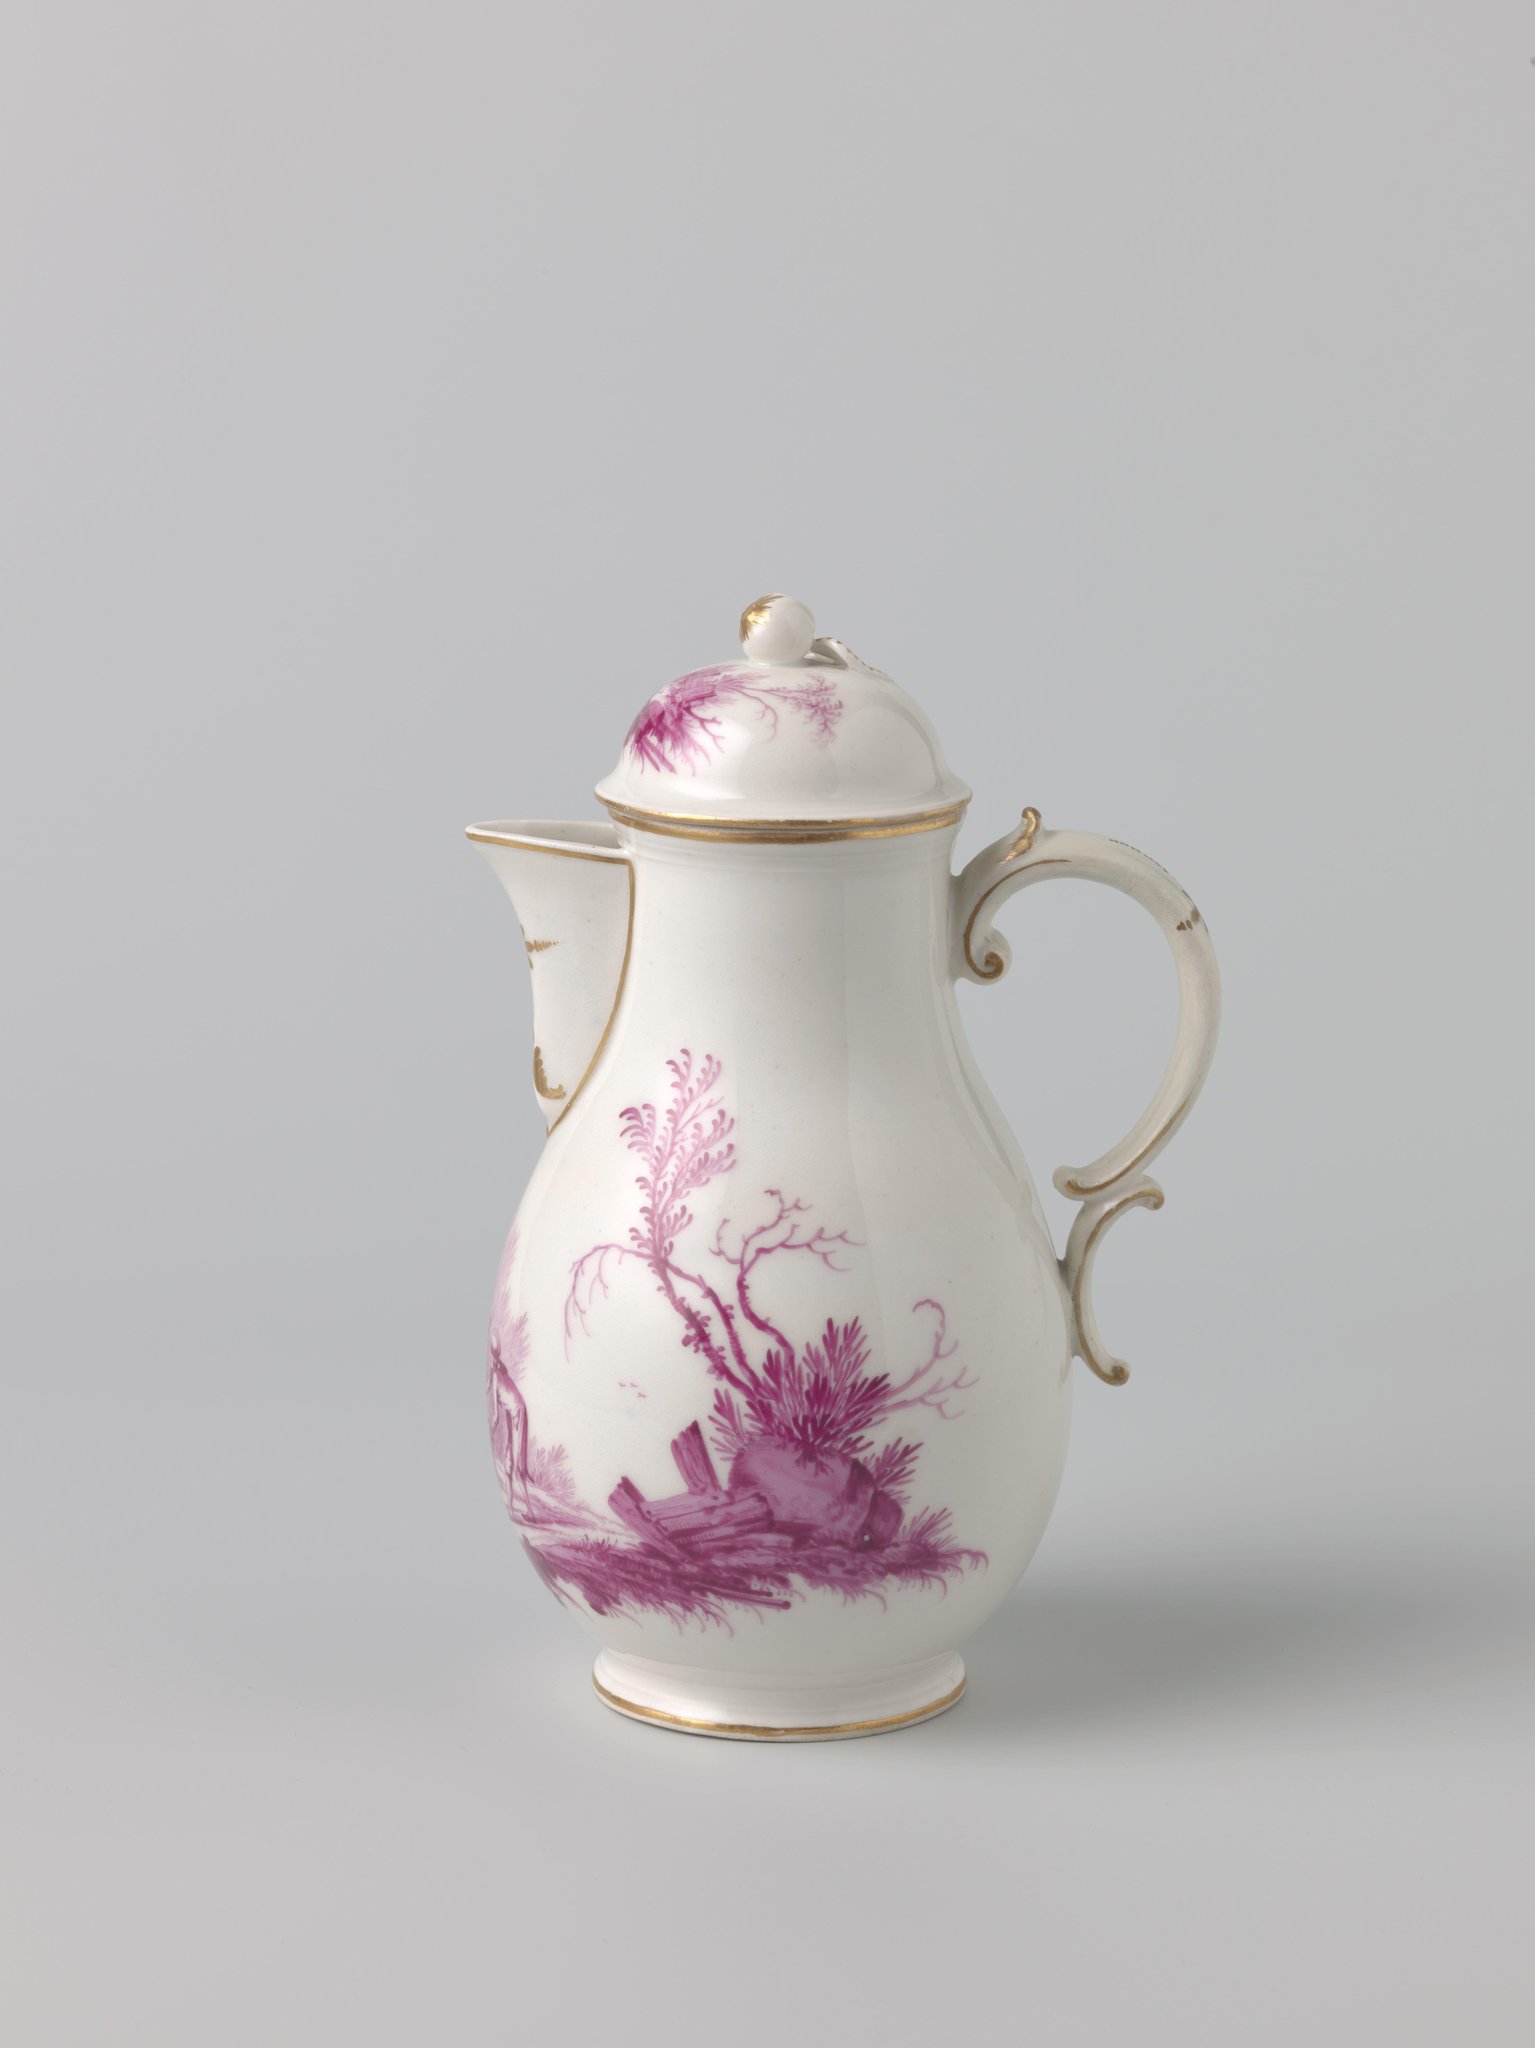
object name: coffee pot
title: Koffiekan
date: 1774-1784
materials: porcelain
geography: loosdrecht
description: Koffiekan van porselein. Beschilderd in lila met een landschap waarin twee figuren en een hond. Langs de randen en tuit gouden motieven.